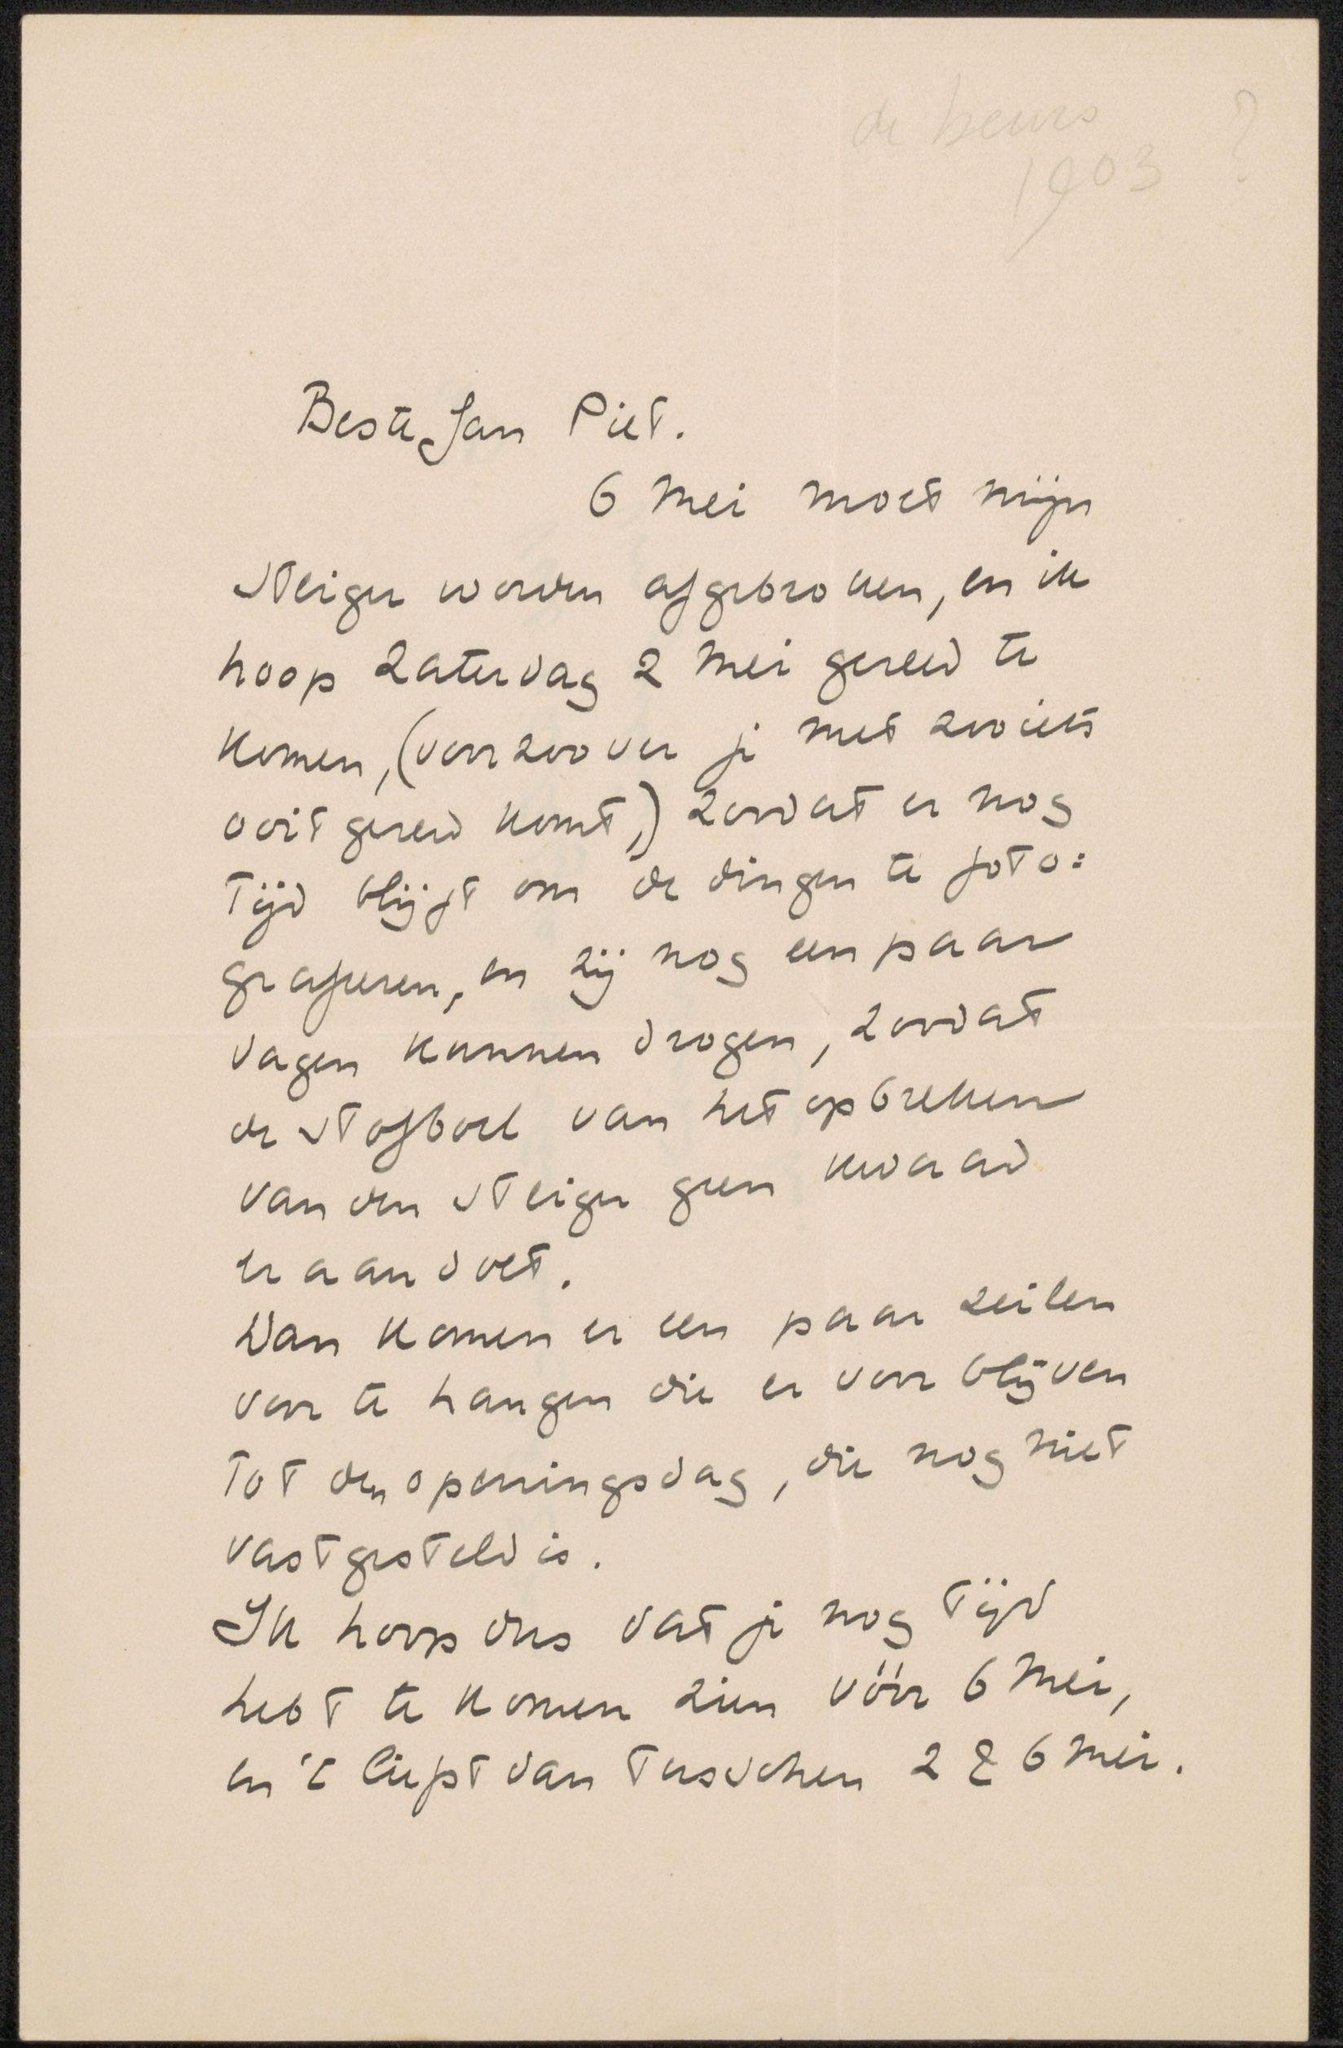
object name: letter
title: Brief aan Jan Veth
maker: richard nicolaüs roland holst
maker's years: 1868-1938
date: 1878-1925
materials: ink, paper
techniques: pen, writing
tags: dordrecht, jan veth, den bosch, amsterdam, painter, print maker, draughtsman, antoon derkinderen, the monumental arts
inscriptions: collector's mark: ‘RPK’